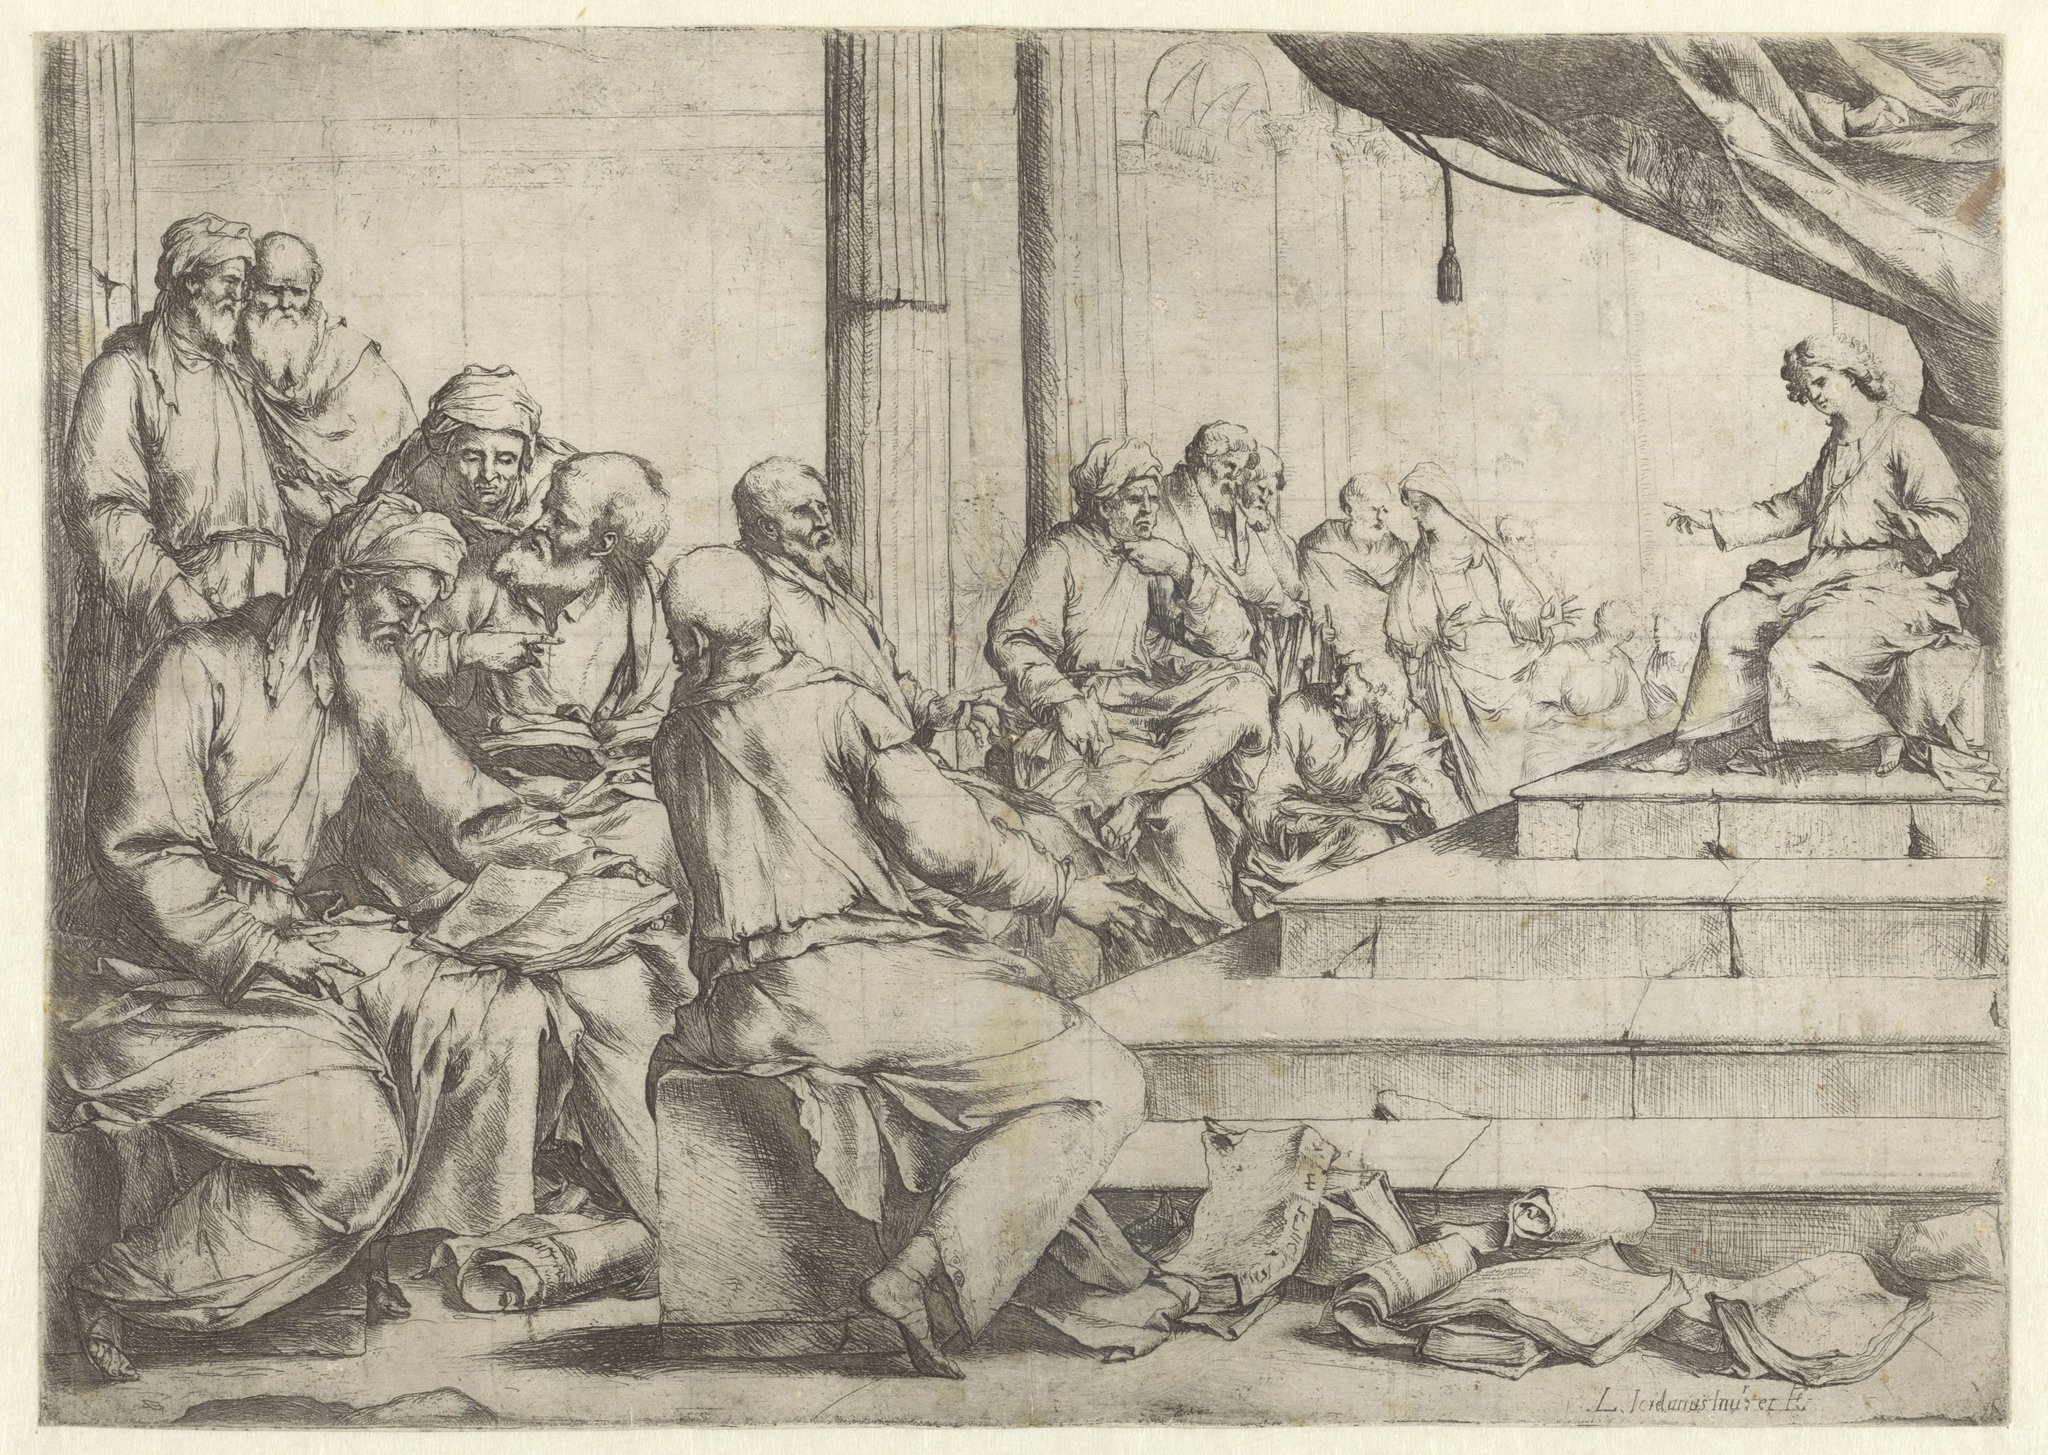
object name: print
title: Christus tussen de schriftgeleerden in de tempel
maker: luca giordano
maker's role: draughtsman, painter, print maker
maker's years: 1632-1705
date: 1644-1705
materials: paper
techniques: etching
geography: italy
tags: christ's dispute with the doctors in the temple; he counts his arguments on his fingers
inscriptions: inscription, number: ‘No. 45.’, collector's mark: Lugt 2760, collector's mark: Lugt 2228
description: De twaalfjarige Christus zit op een verhoging in de tempel. Voor de verhoging zitten de schriftgeleerden.